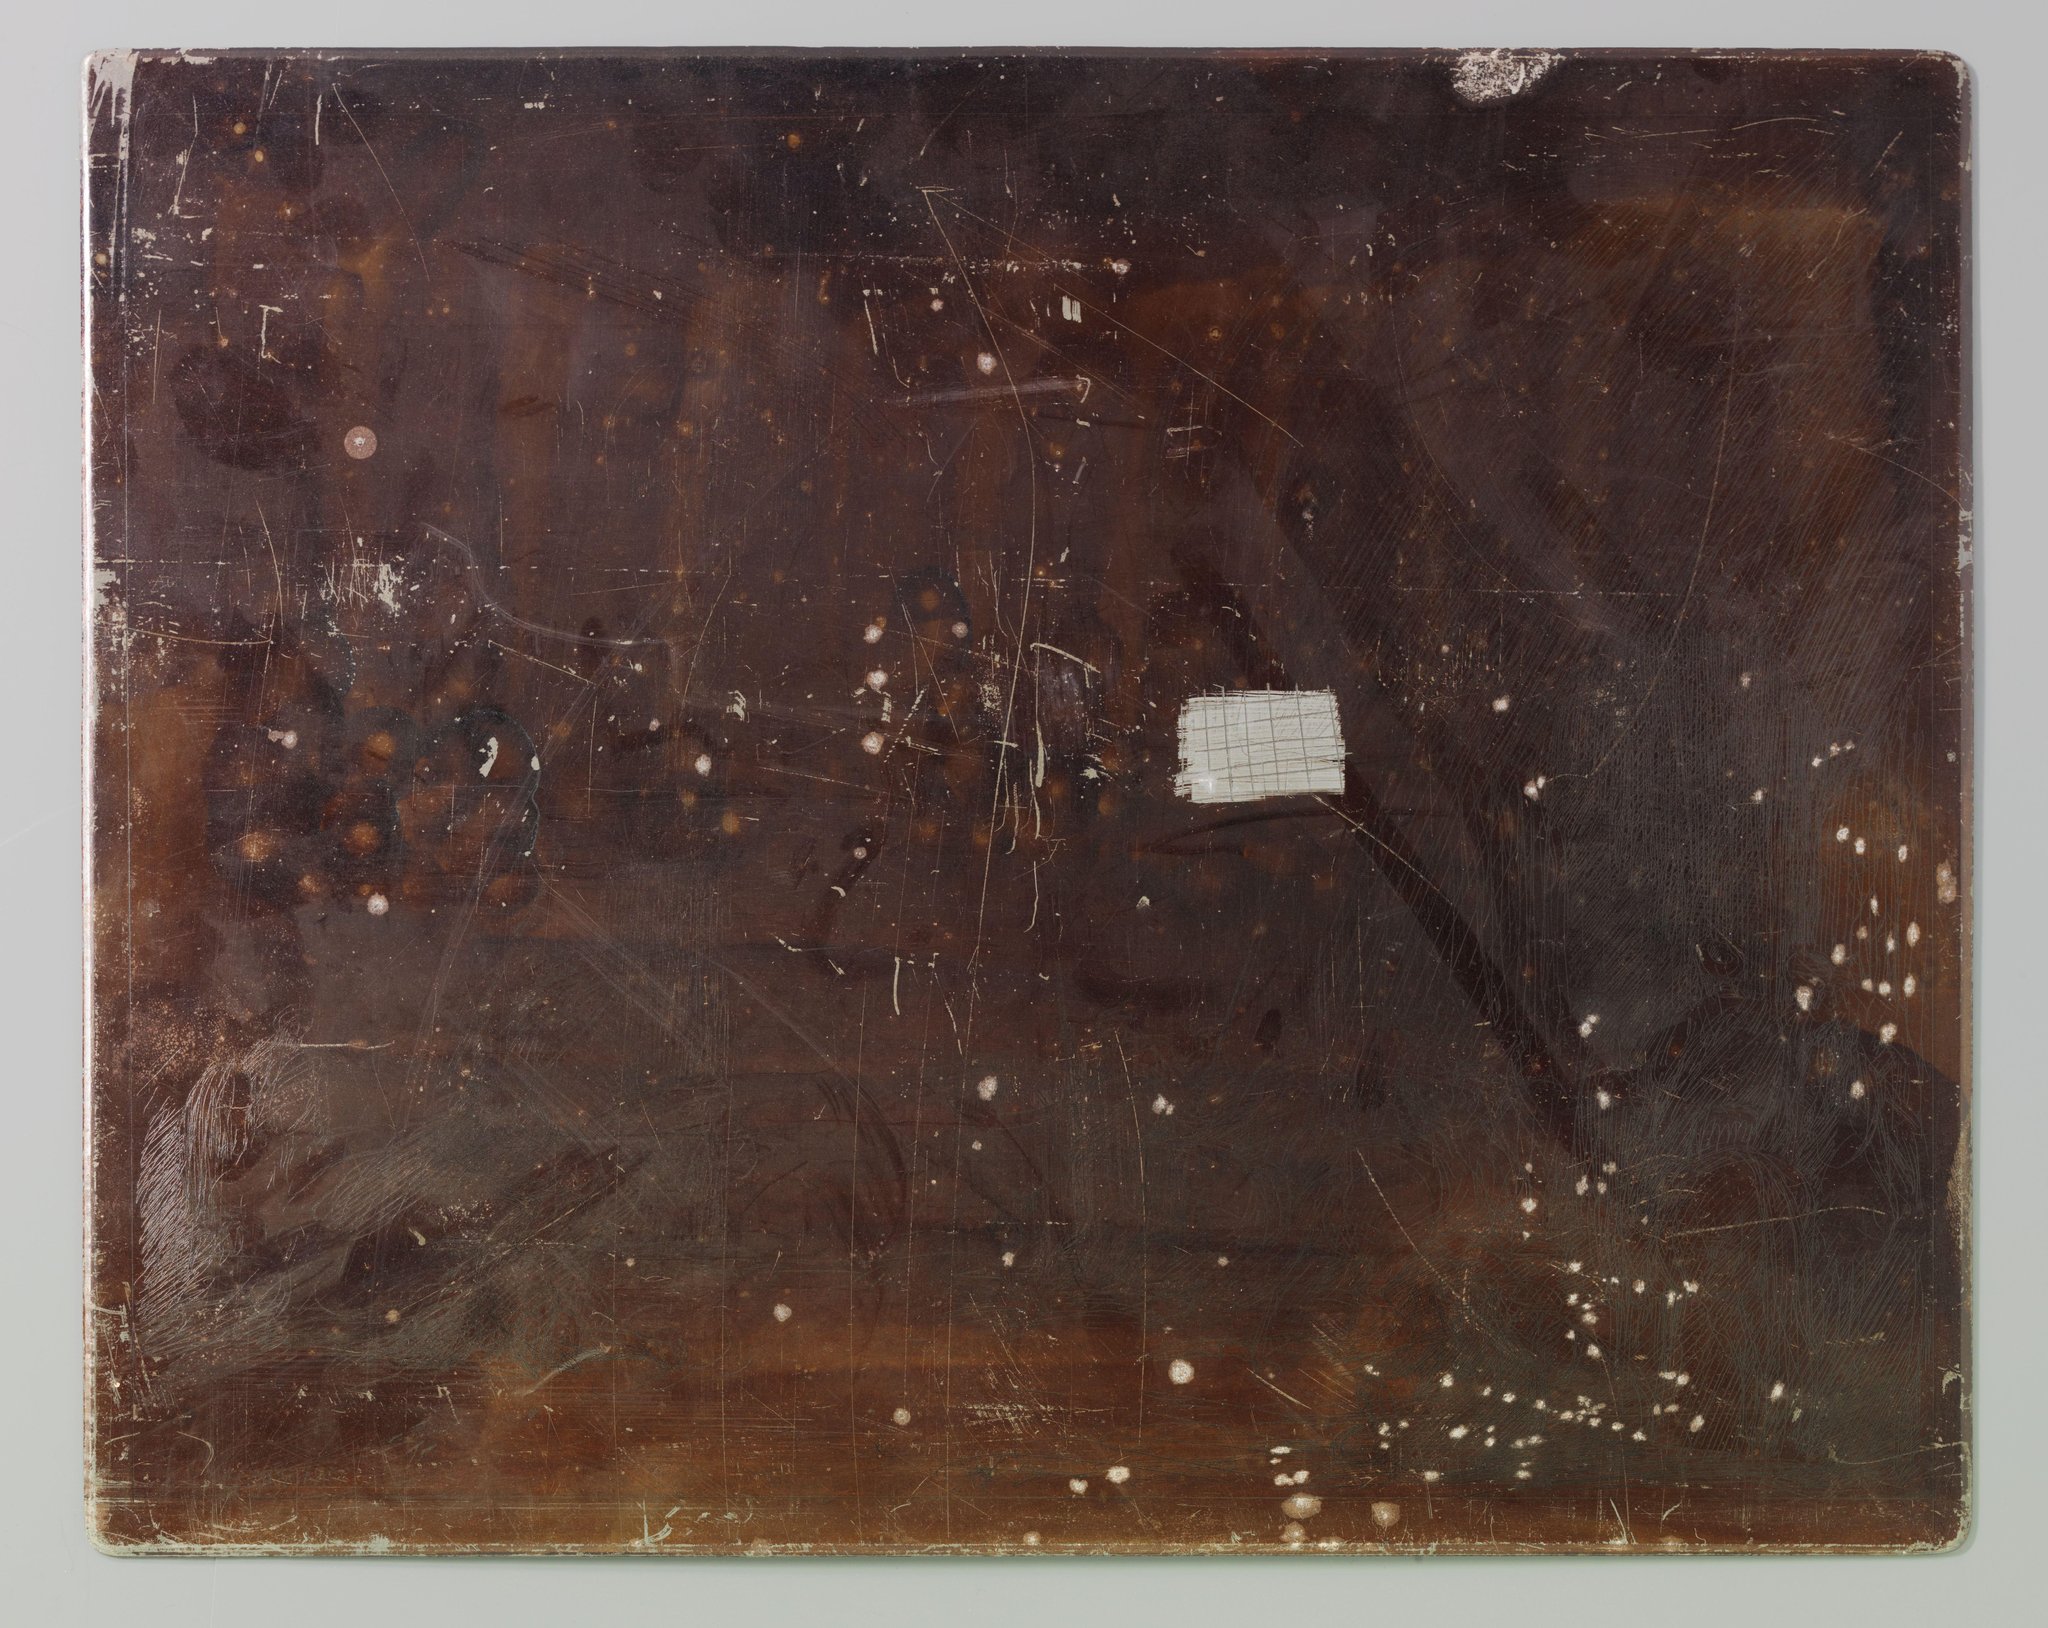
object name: zinkplaat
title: Fantasia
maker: marius bauer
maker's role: draughtsman, print maker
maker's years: 1867-1932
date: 1902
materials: zinc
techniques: etching